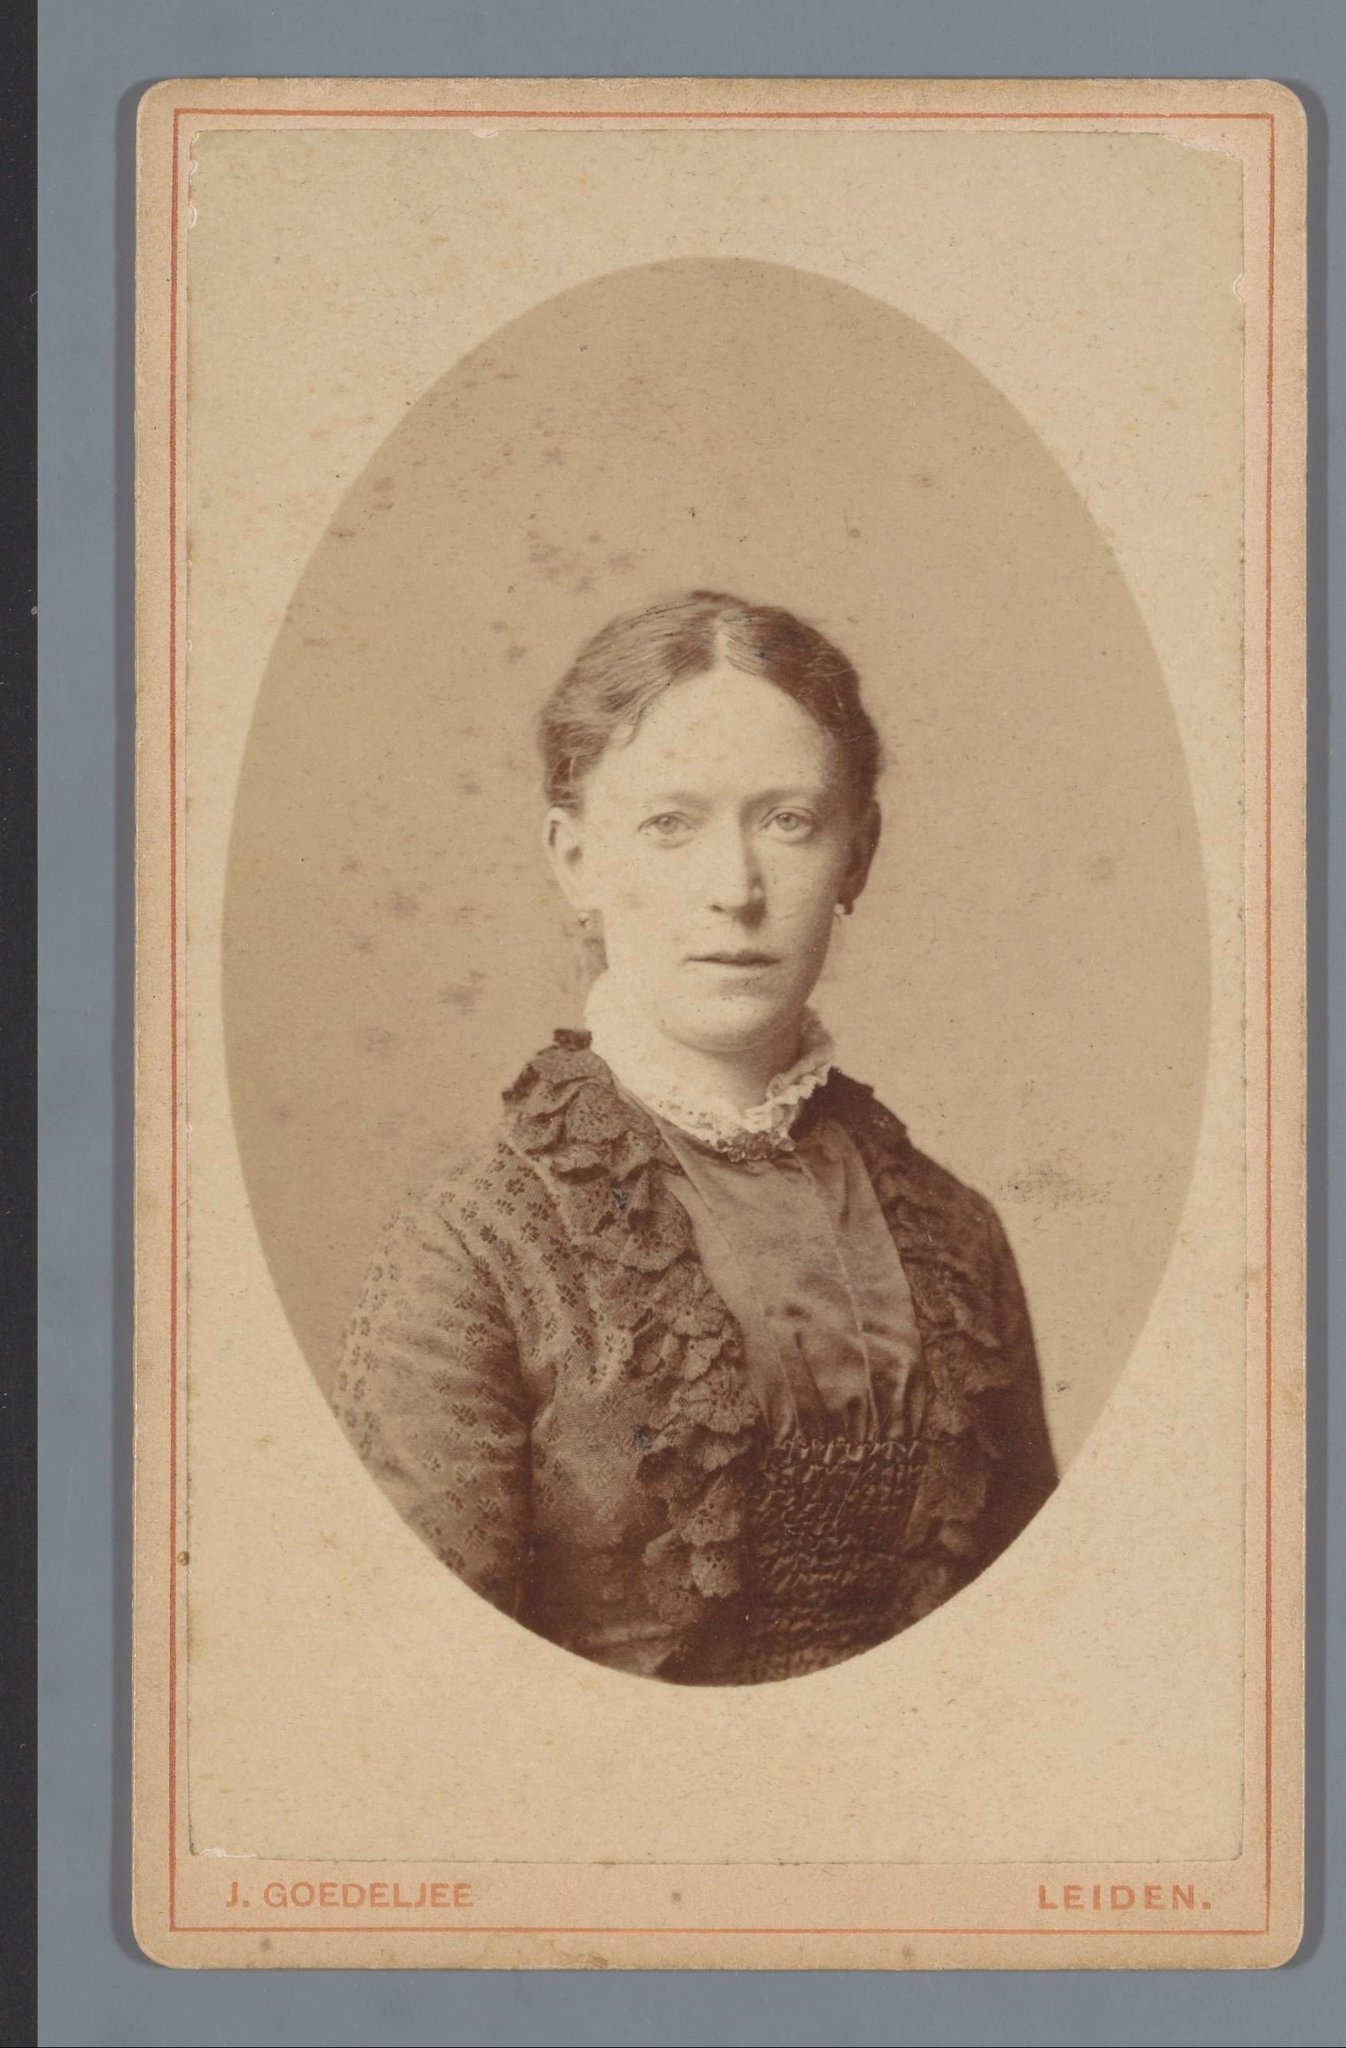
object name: photograph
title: Portret van Russia Agatha Dijkshoorn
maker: jan goedeljee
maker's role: fotograaf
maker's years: 1824-1905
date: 1880-1883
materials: cardboard, photographic support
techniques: albumen print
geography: leiden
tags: gouda, historical persons - bb - woman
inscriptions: address: ‘J. Goedeljee/ Photograaf/ van/ Z.K.H. PRINS ALEXANDER/ der Nederlanden/ PRINS van ORANJE/ EN H.K.H./ PRINSES HENDRIK/ der Nederlanden./ LEIDEN/ Hoogewoerd 160/ nabij de Plantage.’, annotation: ‘Russie Agatha Dyxhoorn/ geb: te Gouda 27 Juni 1846/ overl - - 12 Sept 1899’